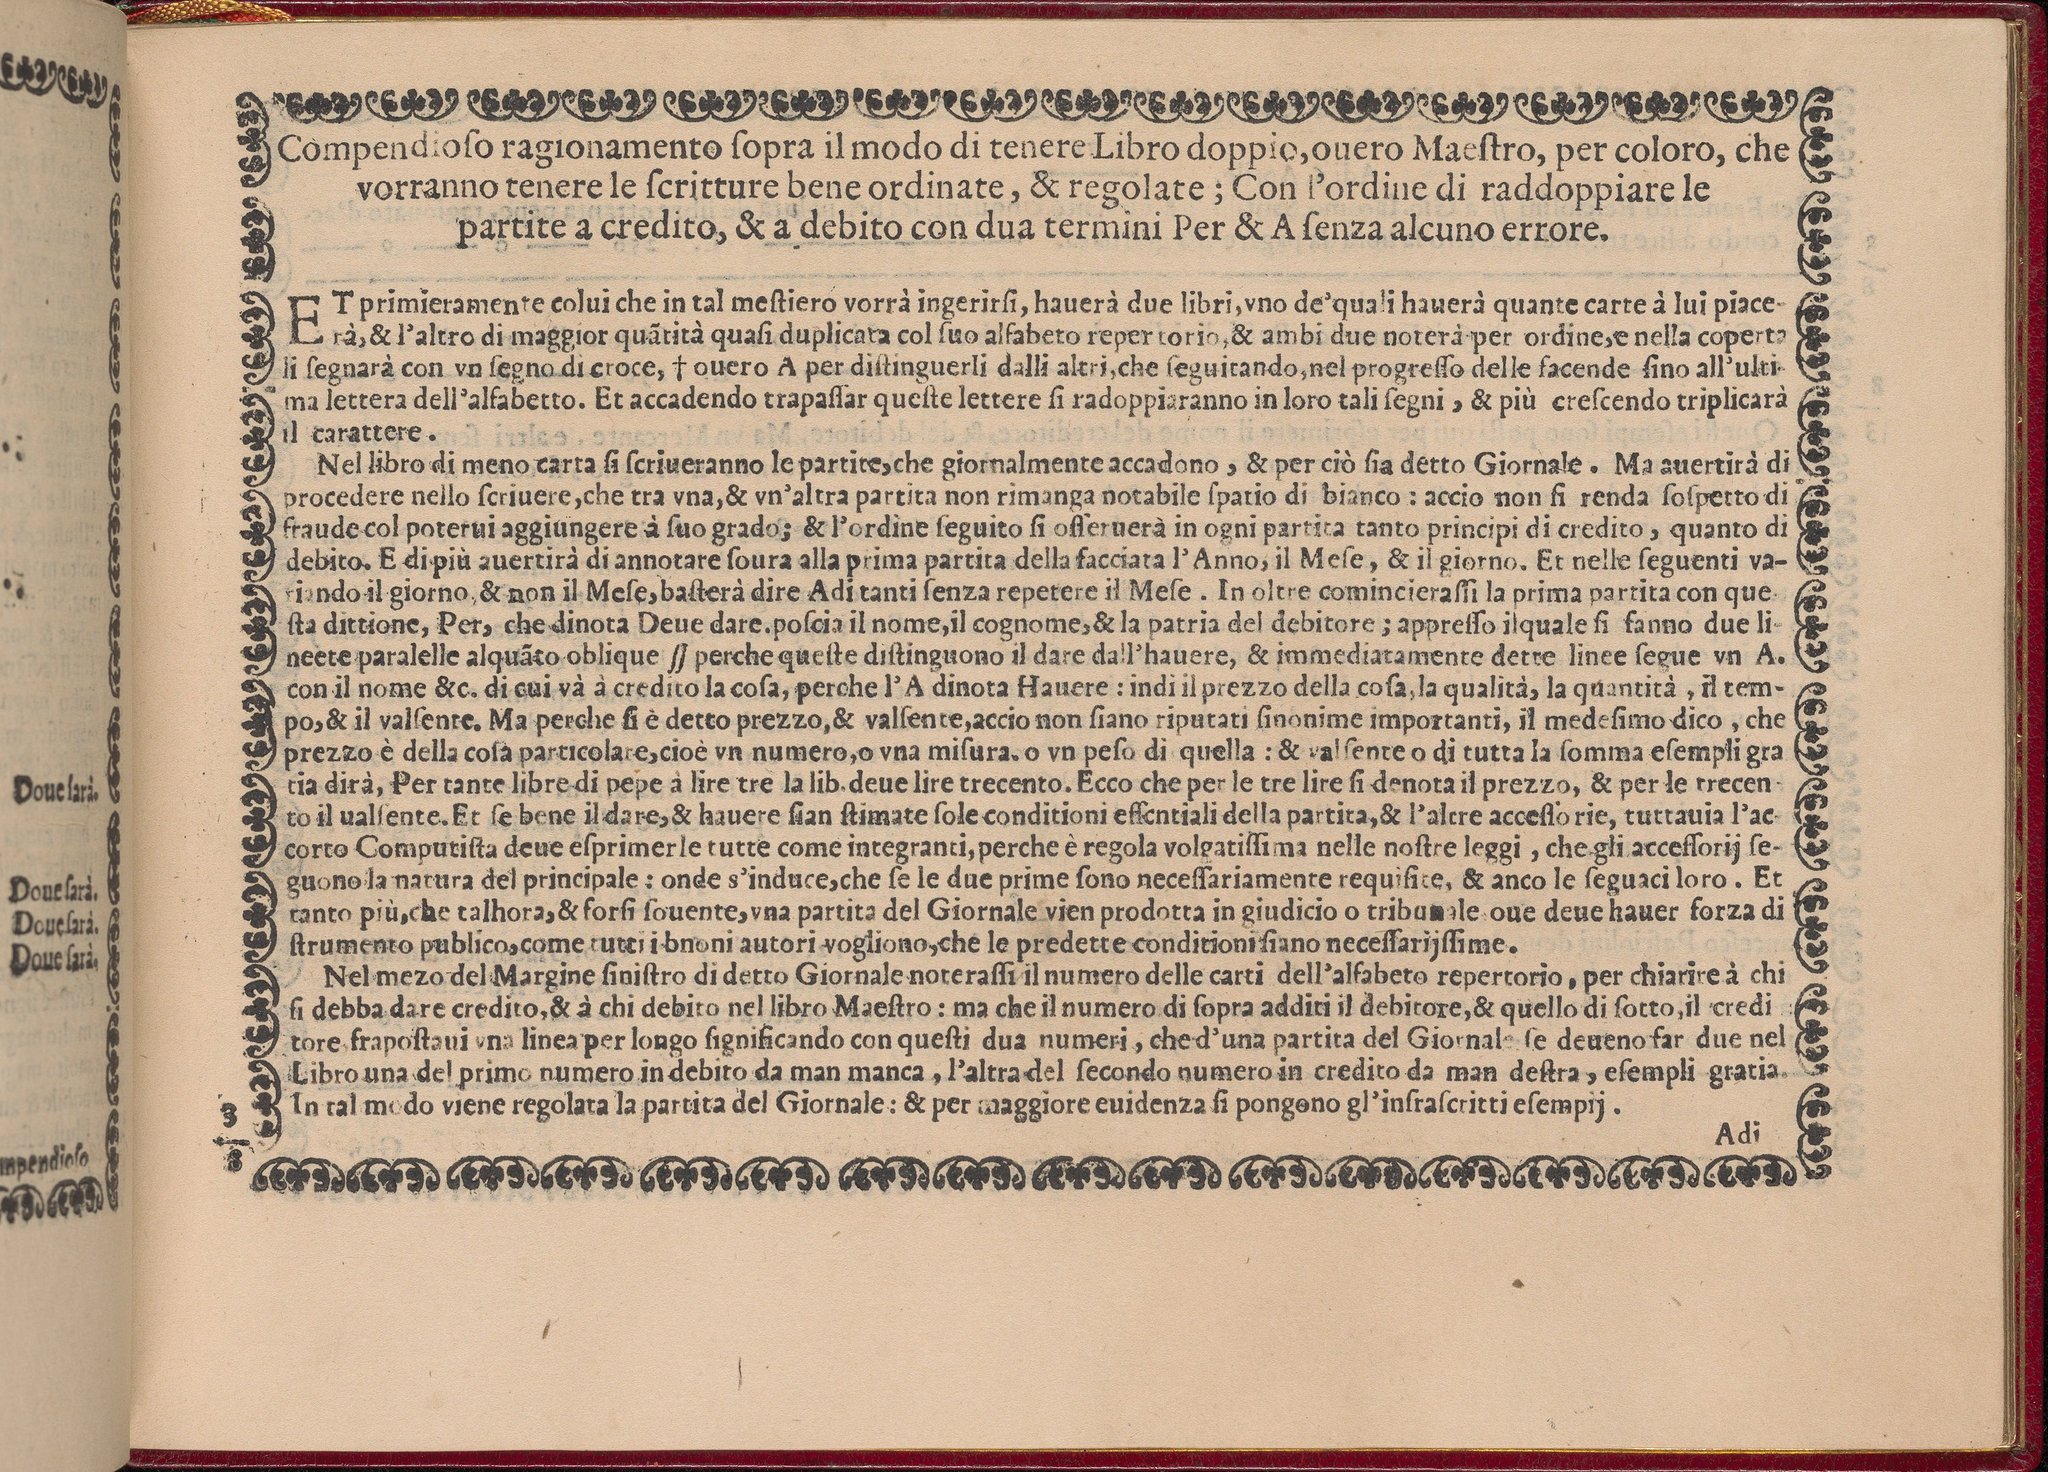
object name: book print ornament architecture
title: Ghirlanda: Di sei vaghi fiori scielti da piu famosi Giardini d'Italia, page 7 (recto)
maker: pietro paulo tozzi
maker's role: designer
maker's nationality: italian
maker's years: 1593-1628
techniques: drawing, etching